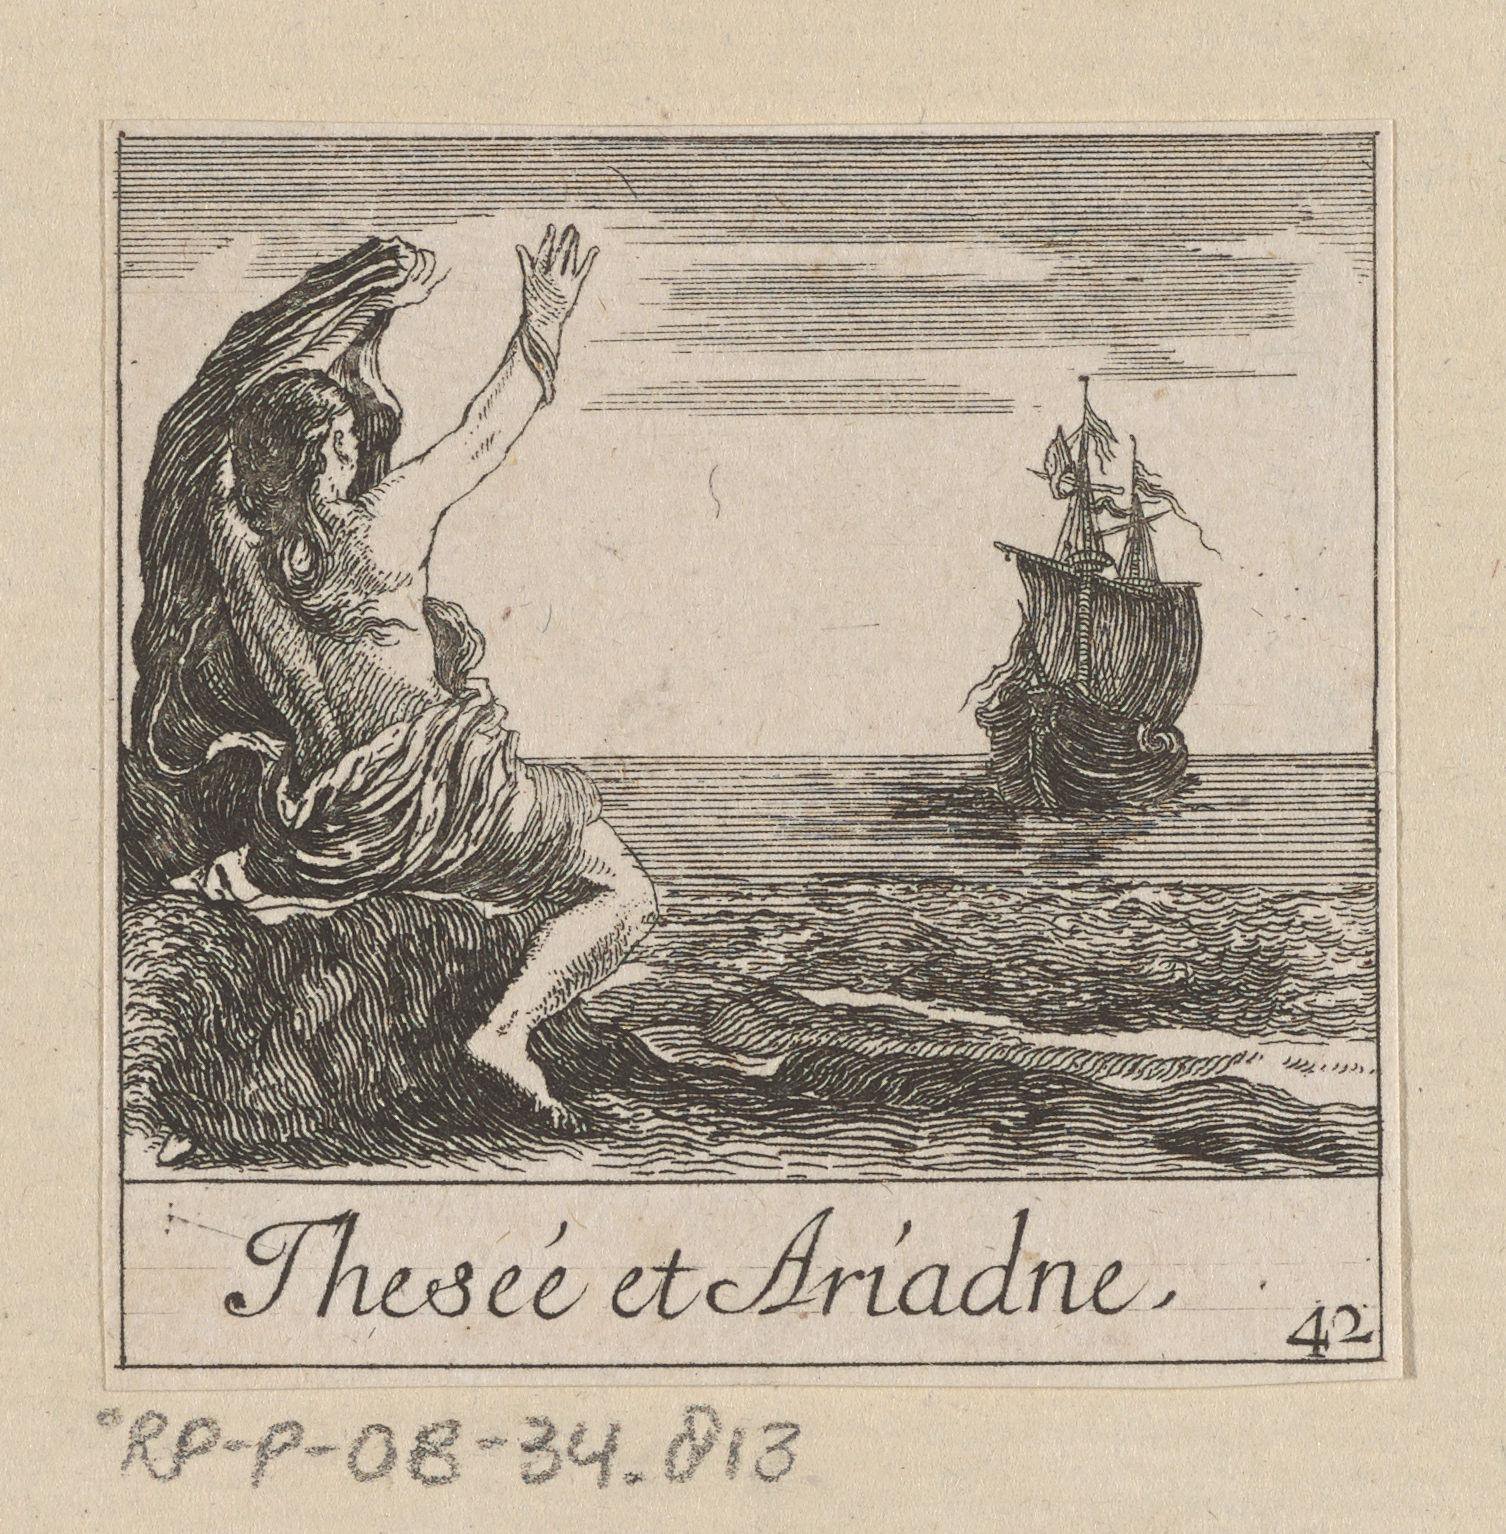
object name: print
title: Theseus en Ariadne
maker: Anonymous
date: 1620-1664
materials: paper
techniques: etching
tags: ariadne left behind on the island of naxos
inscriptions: collector's mark: Lugt 240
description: Prent uit een reeks van 54 genummerde speelkaarten met voorstellingen uit de Metamorfosen van Ovidius.